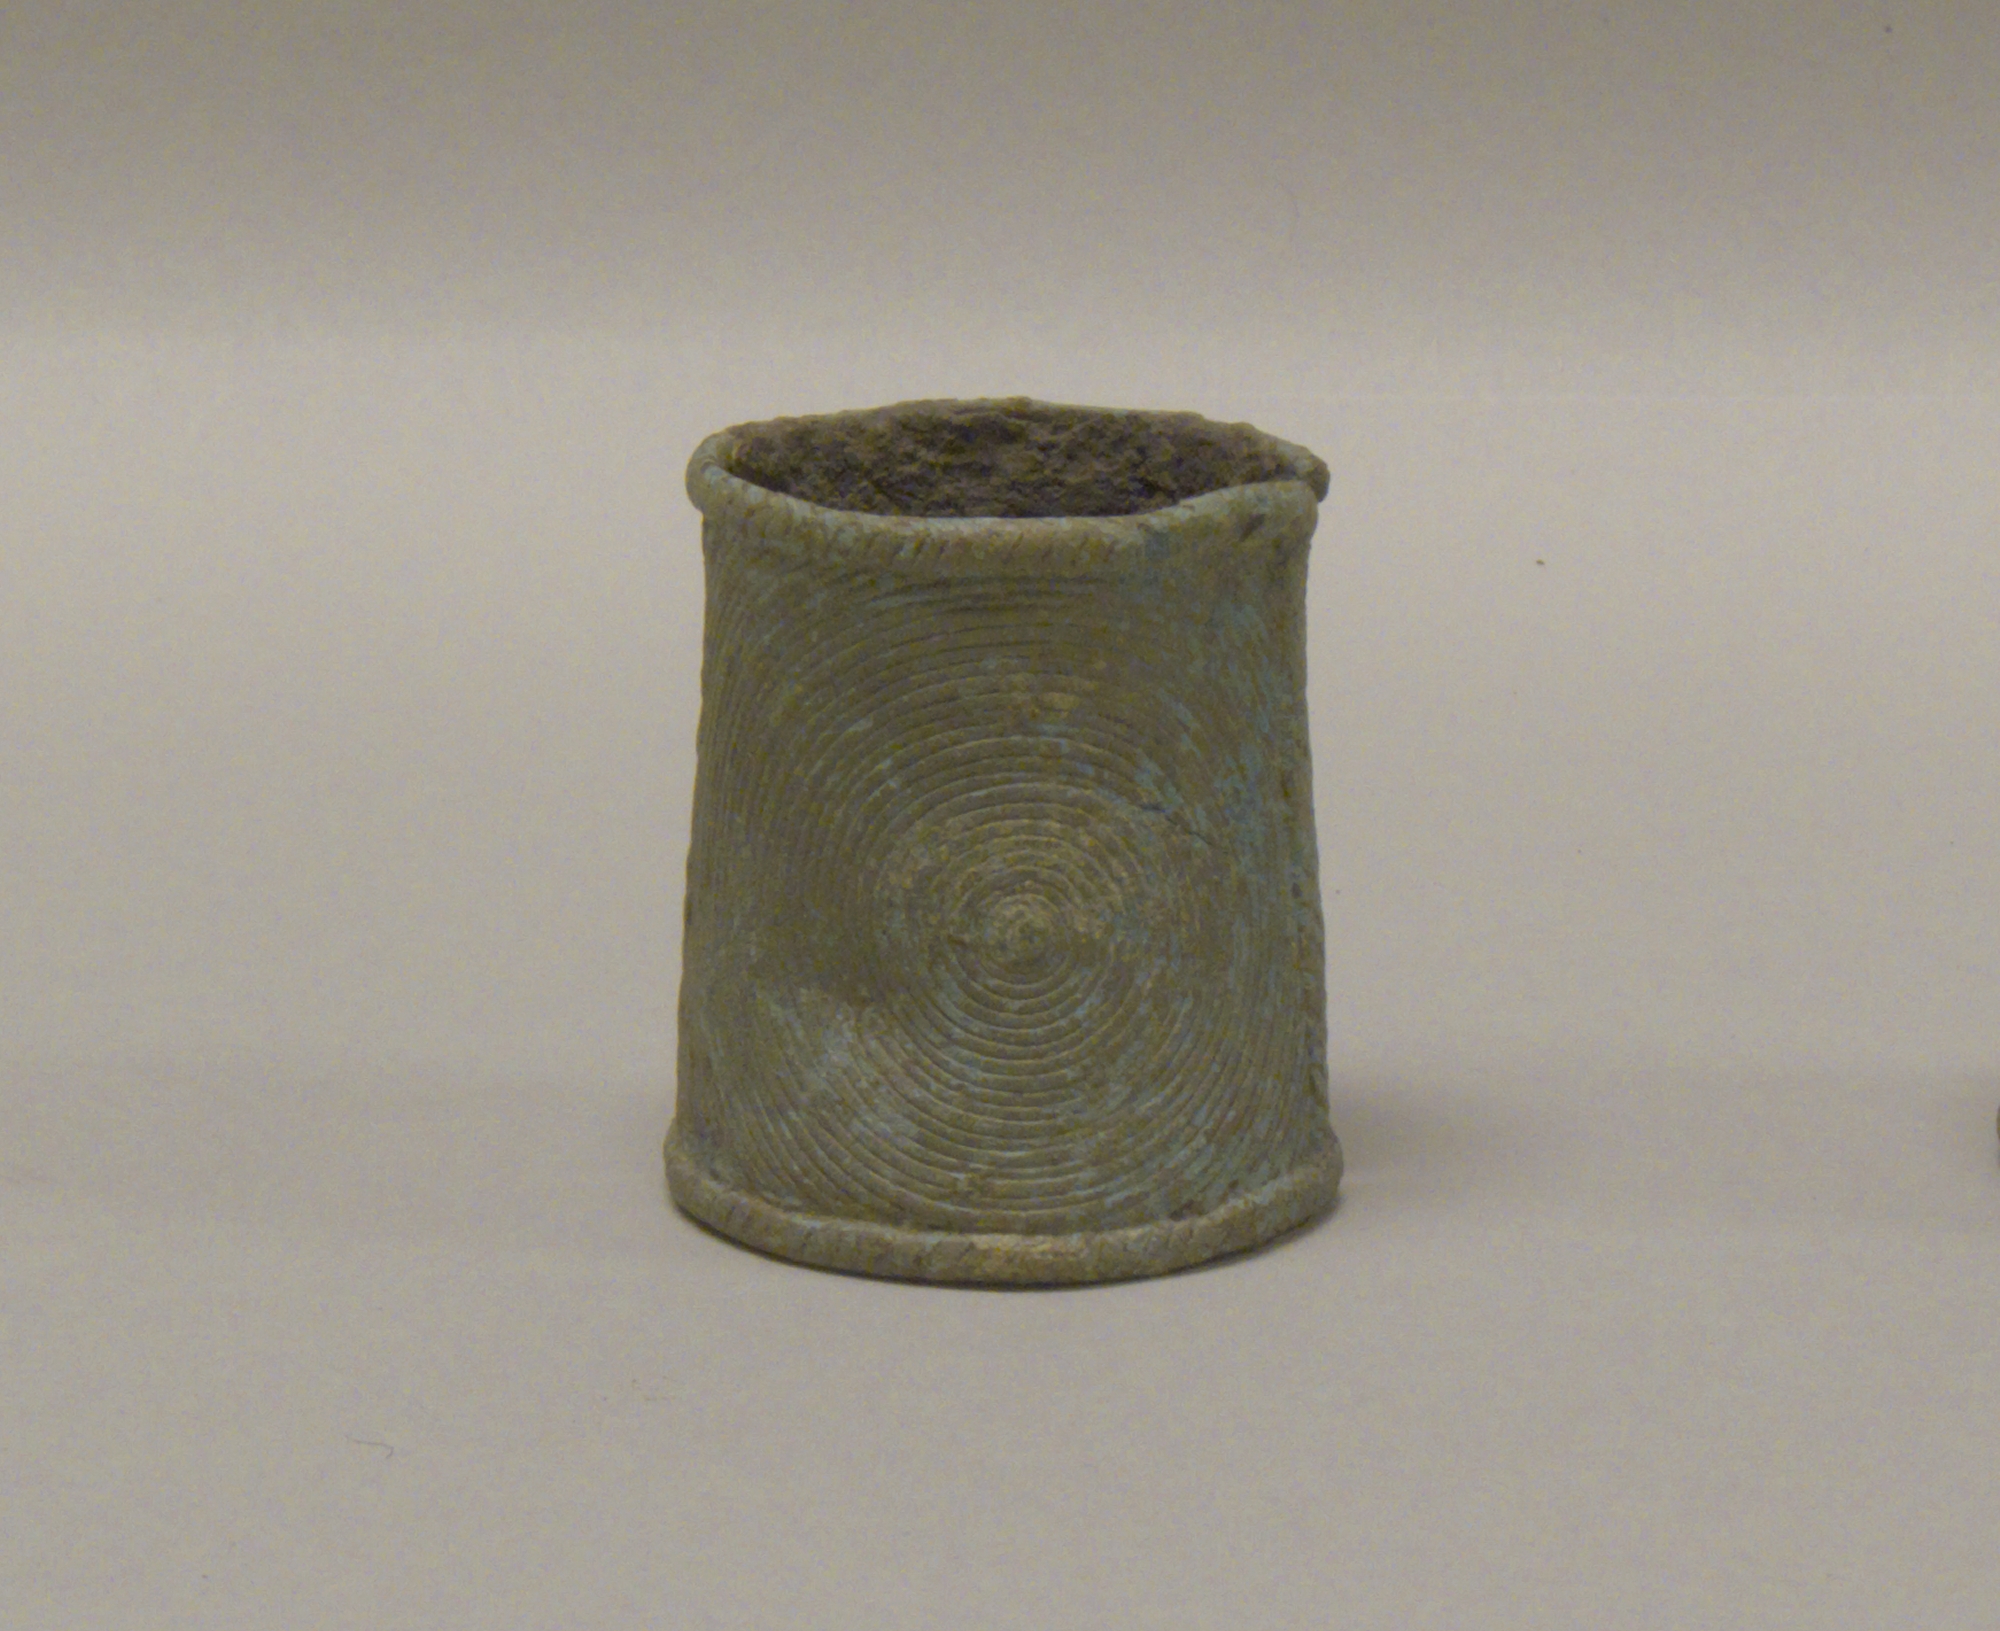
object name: one of a pair of cuff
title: One of a Pair of Cuffs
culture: thai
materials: bronze